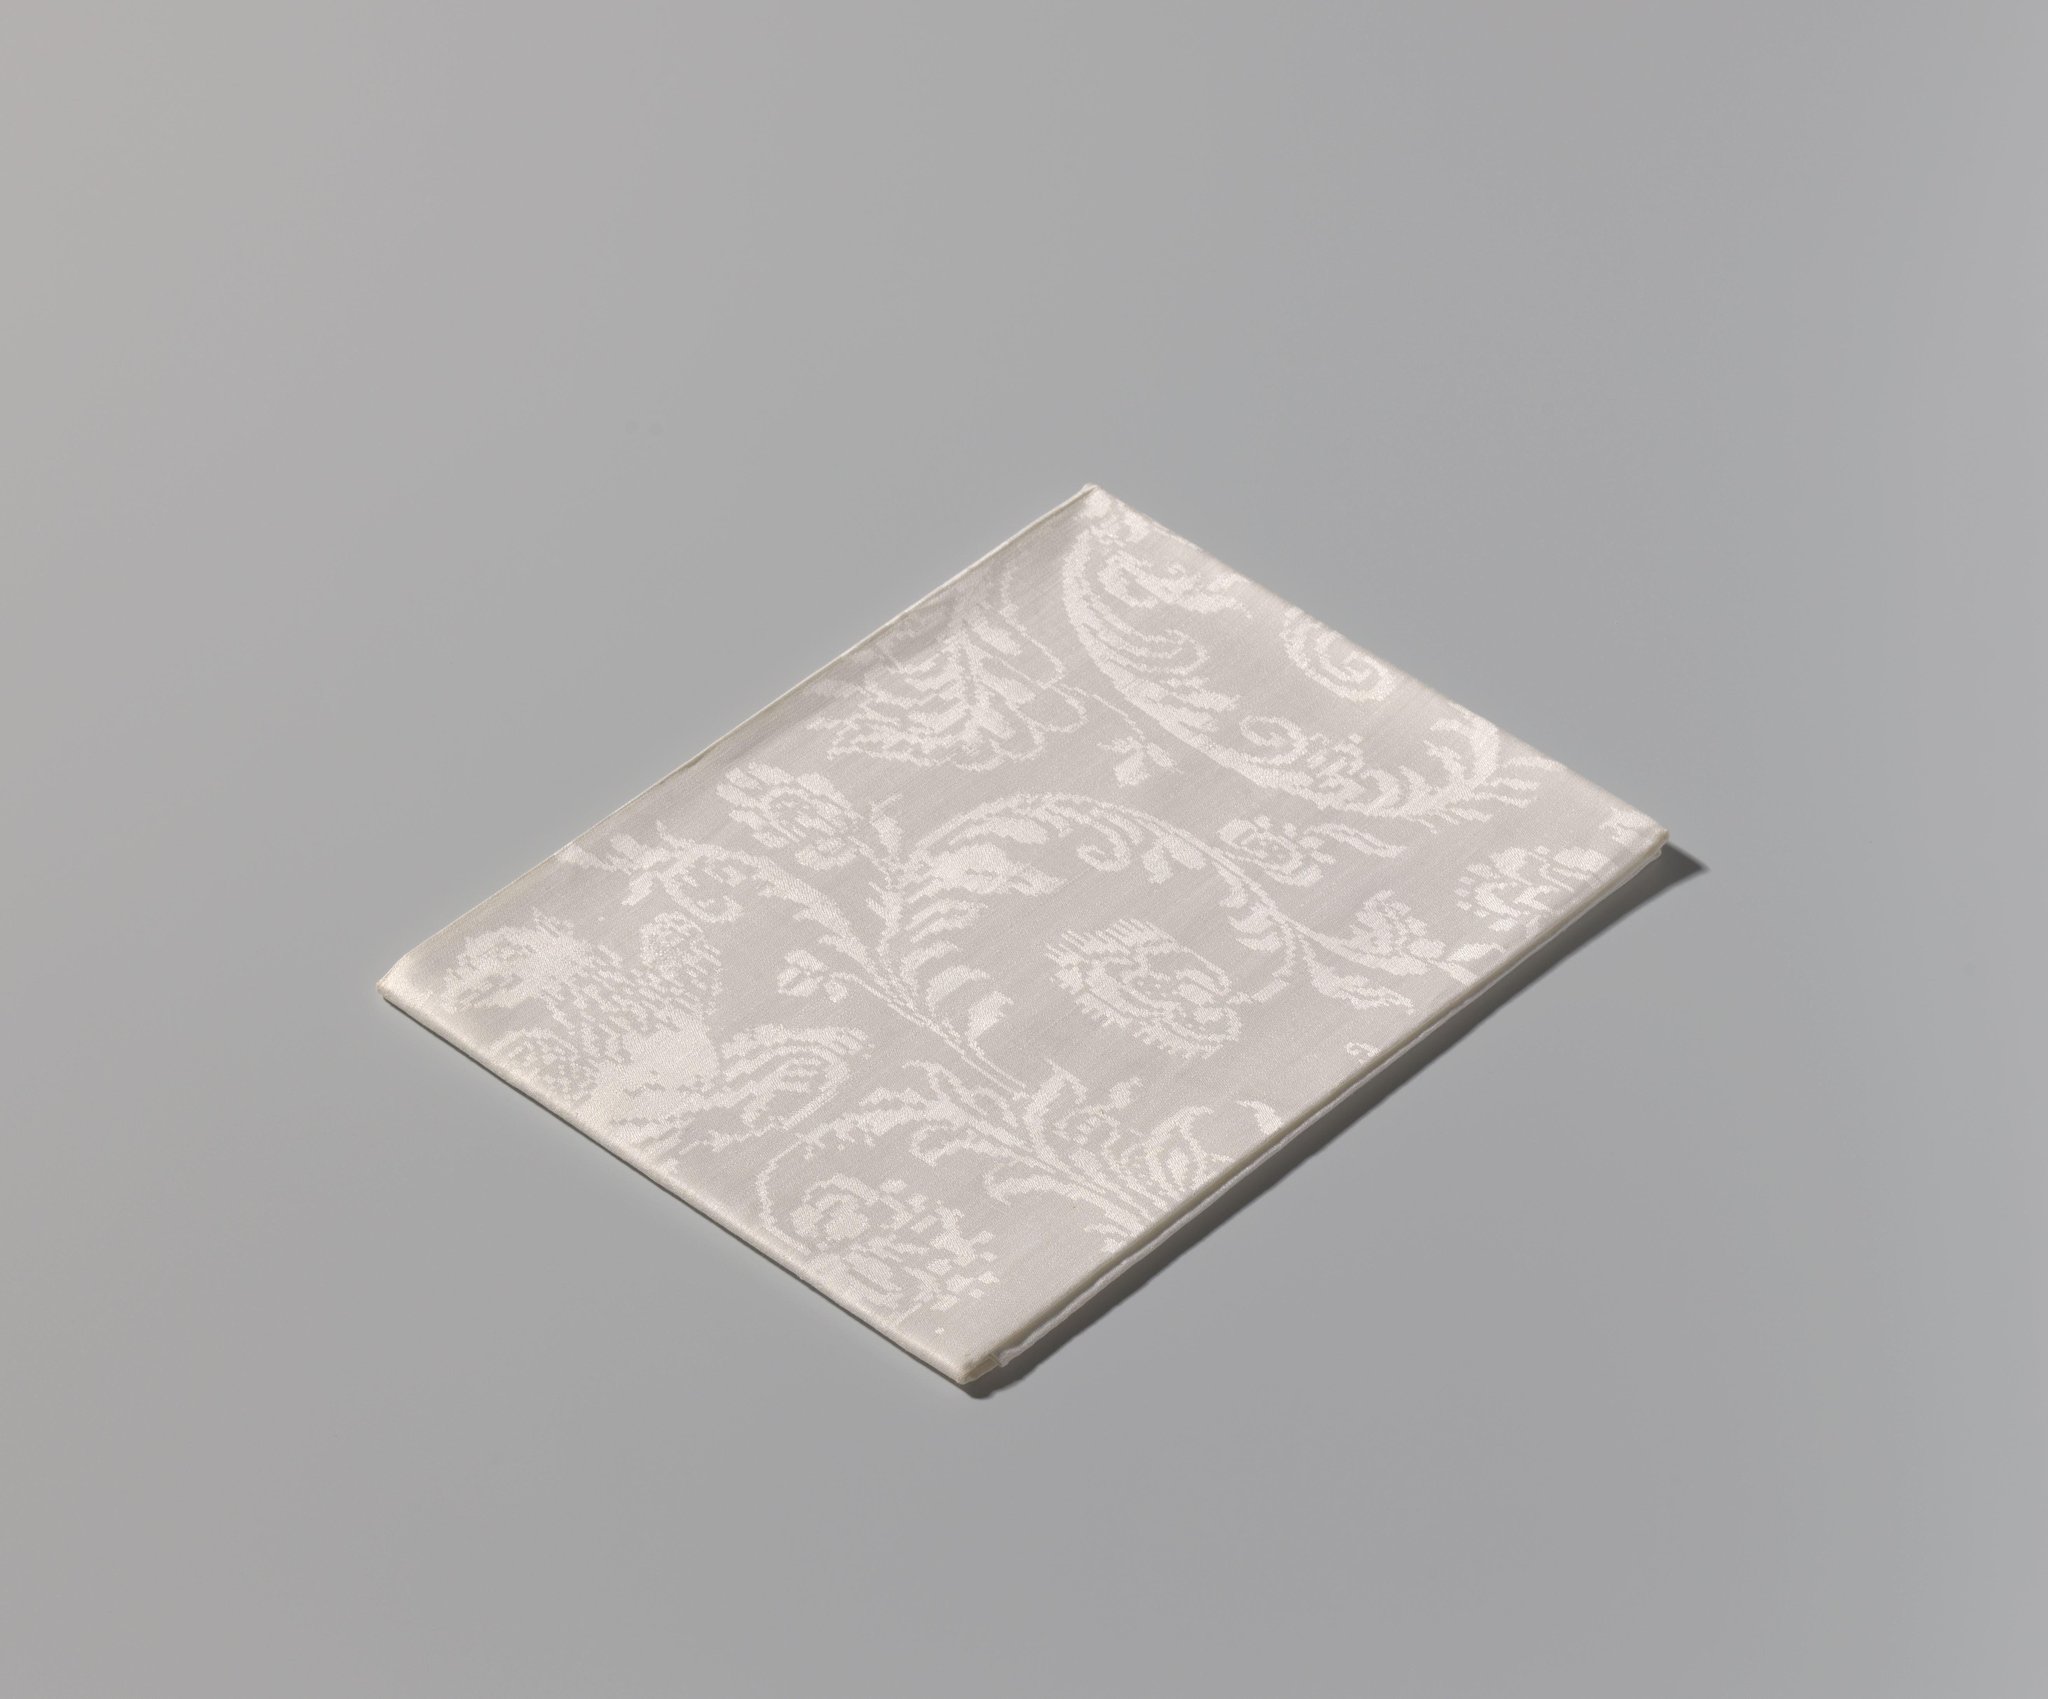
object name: napkin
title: Servet met het wapen van Cornelis Hop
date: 1700-1724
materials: linen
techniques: damask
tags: cornelis hop (ii)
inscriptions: mark: ‘H’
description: Servet van linnendamast met het wapen van Cornelis Hop. Middenveld: symmetrische patroon van veelsoortige voluutranken met op de knooppunten geblokte verdikkingen. Daartussen een liggend ovaal schild met een wapen van Cornelis Hop (1685-1762), ambassadeur aan het hof van koning Lodewijk XV van Frankrijk: gevierendeeld, 1 en 4 kopvogel staande op bol (de vogel van 1 omgewend, die van 4 omziend); 2 en drie twee afgewende vleugels. Hartschild gedeeld: 1 een dwarsbalk, 2 rechts een vijfpuntige ster, links een gewende wassenaar. Het schild gedekt met vijfbladerige kroon. Schildhouders: rechts een afgewende adelaar, links een afgewende leeuw. Randen: wapentrofeeën. Hoeken: een rondas. Rondom blokkenrand.